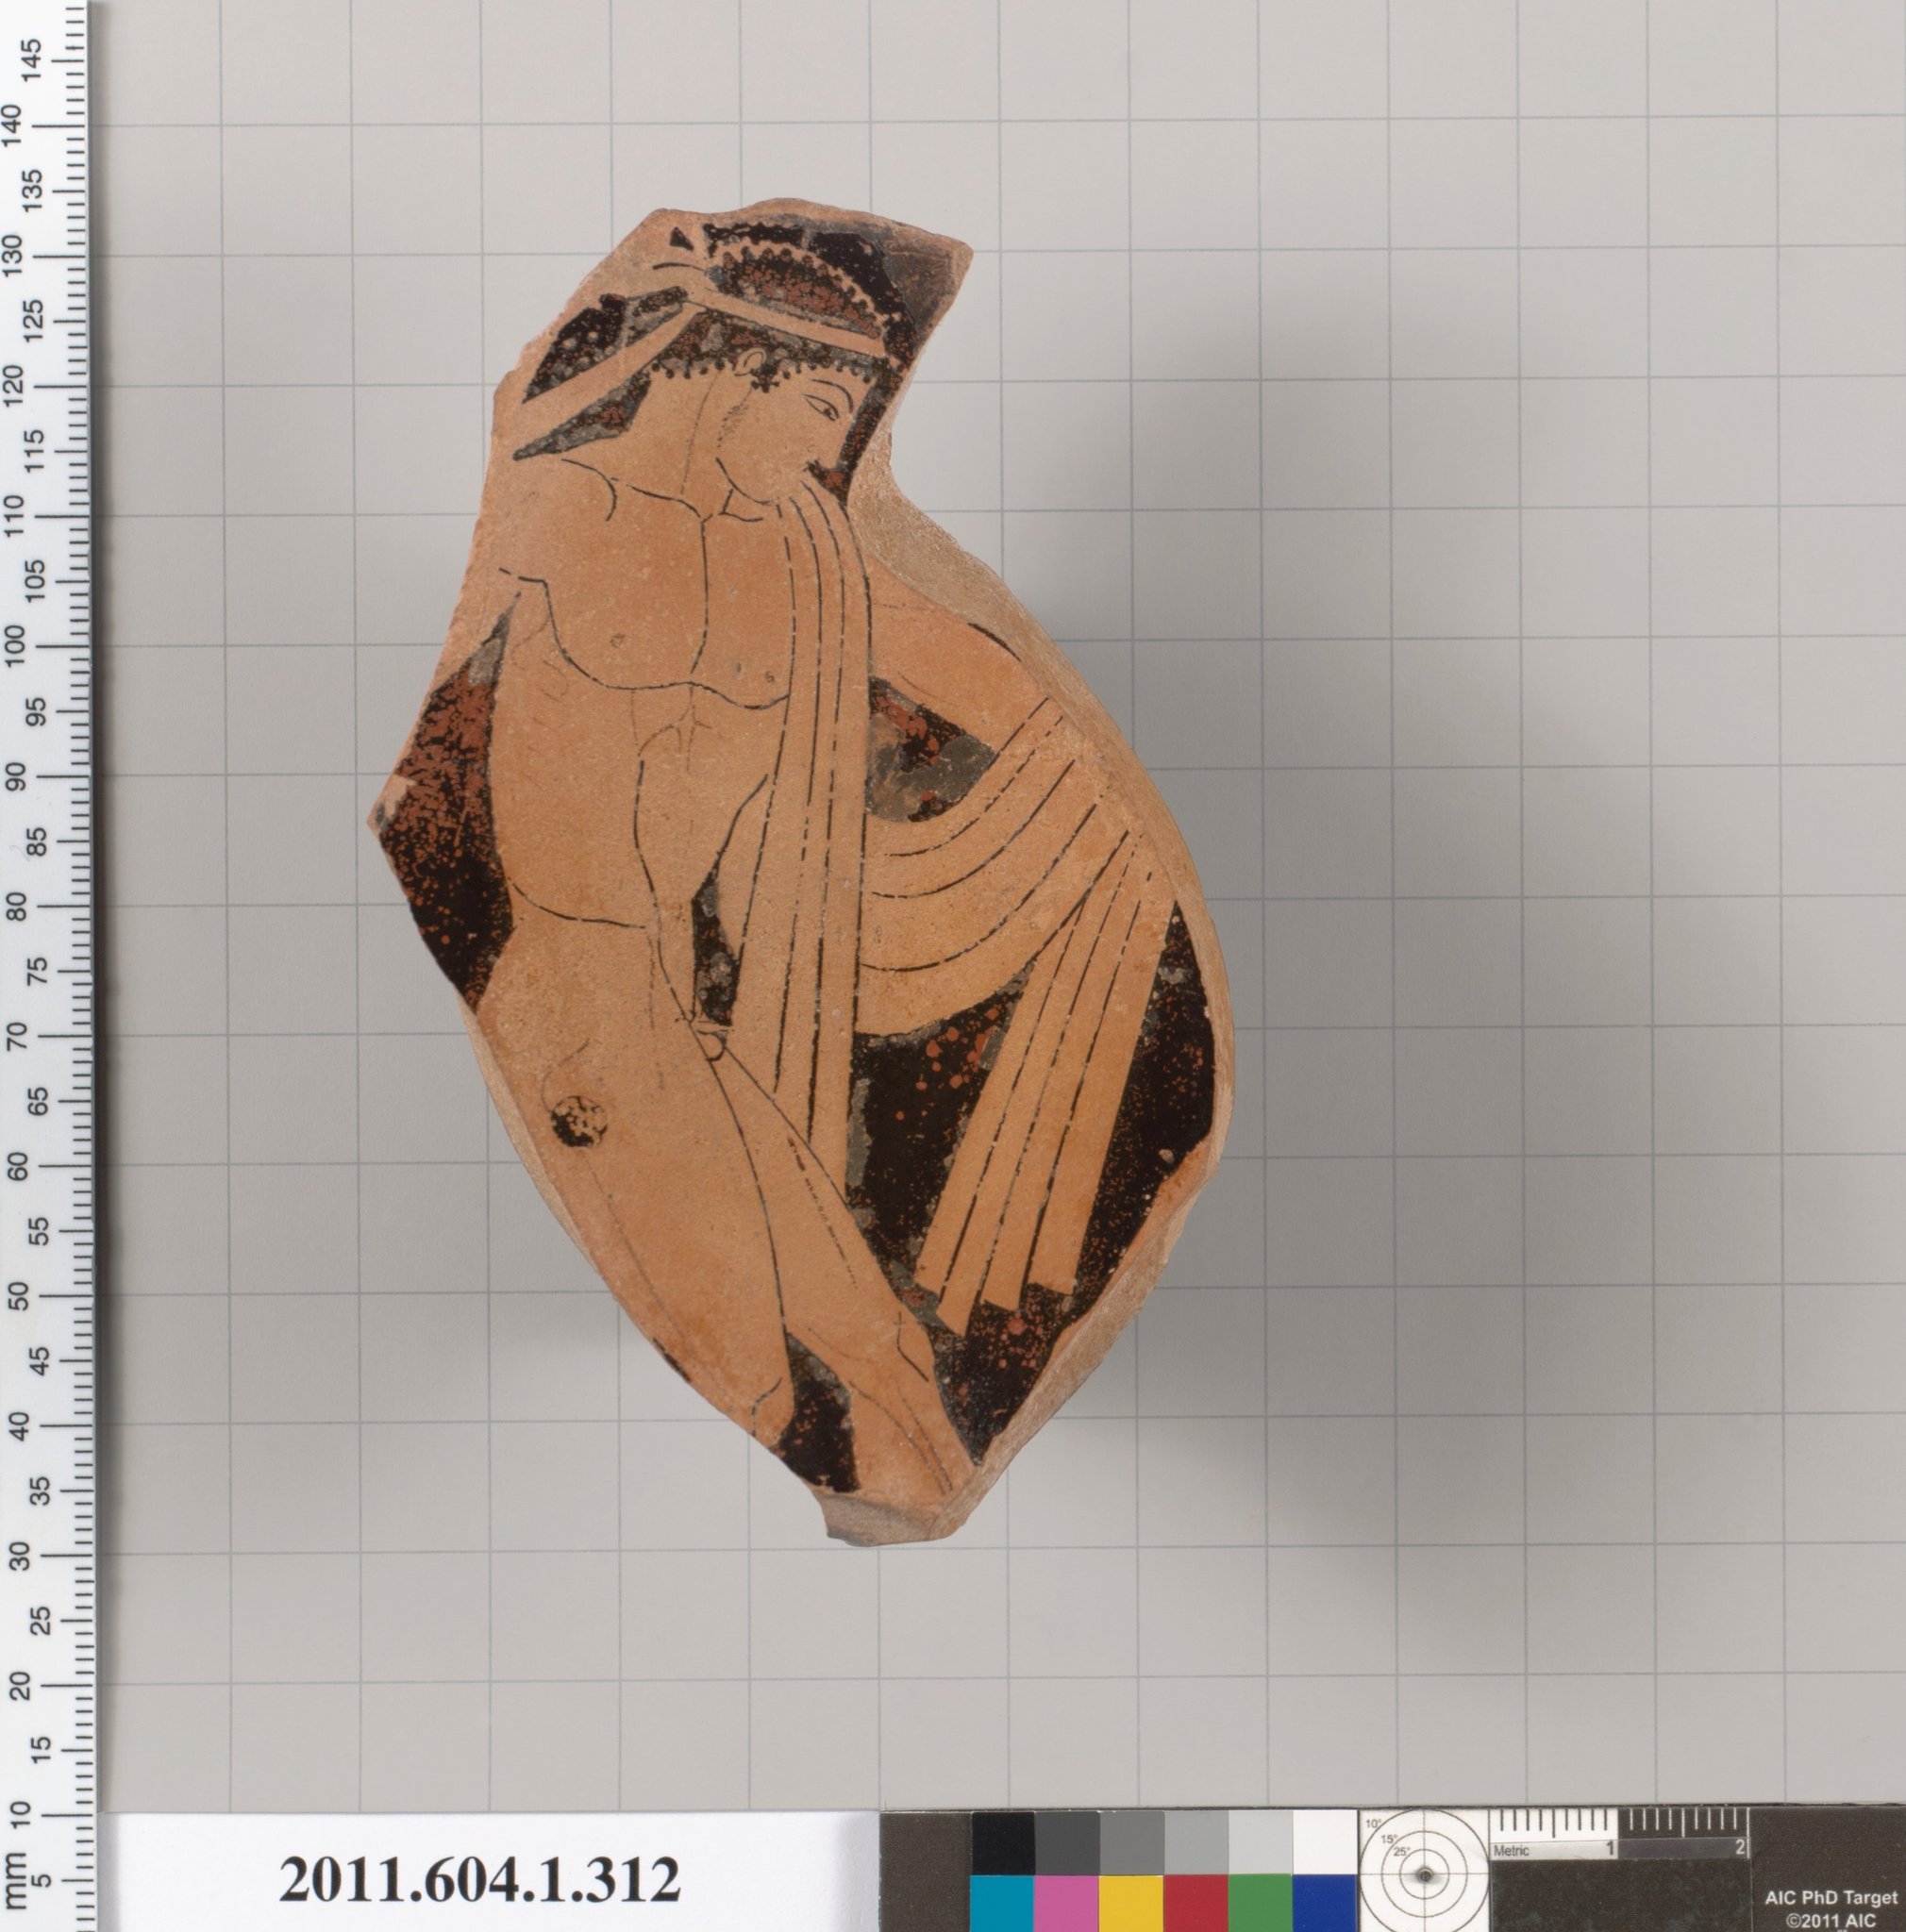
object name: kylix fragment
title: Terracotta fragment of a kylix (drinking cup)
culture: greek, attic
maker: pistoxenos painter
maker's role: artist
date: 475-451 BCE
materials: terracotta